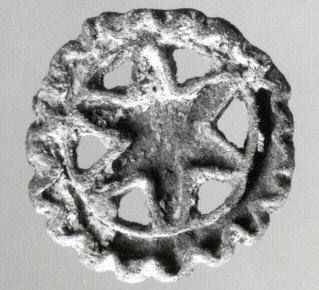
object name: stamp seal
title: Compartmented stamp seal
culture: bactria-margiana archaeological complex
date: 2333-1668 BCE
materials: copper alloy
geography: bactria-margiana